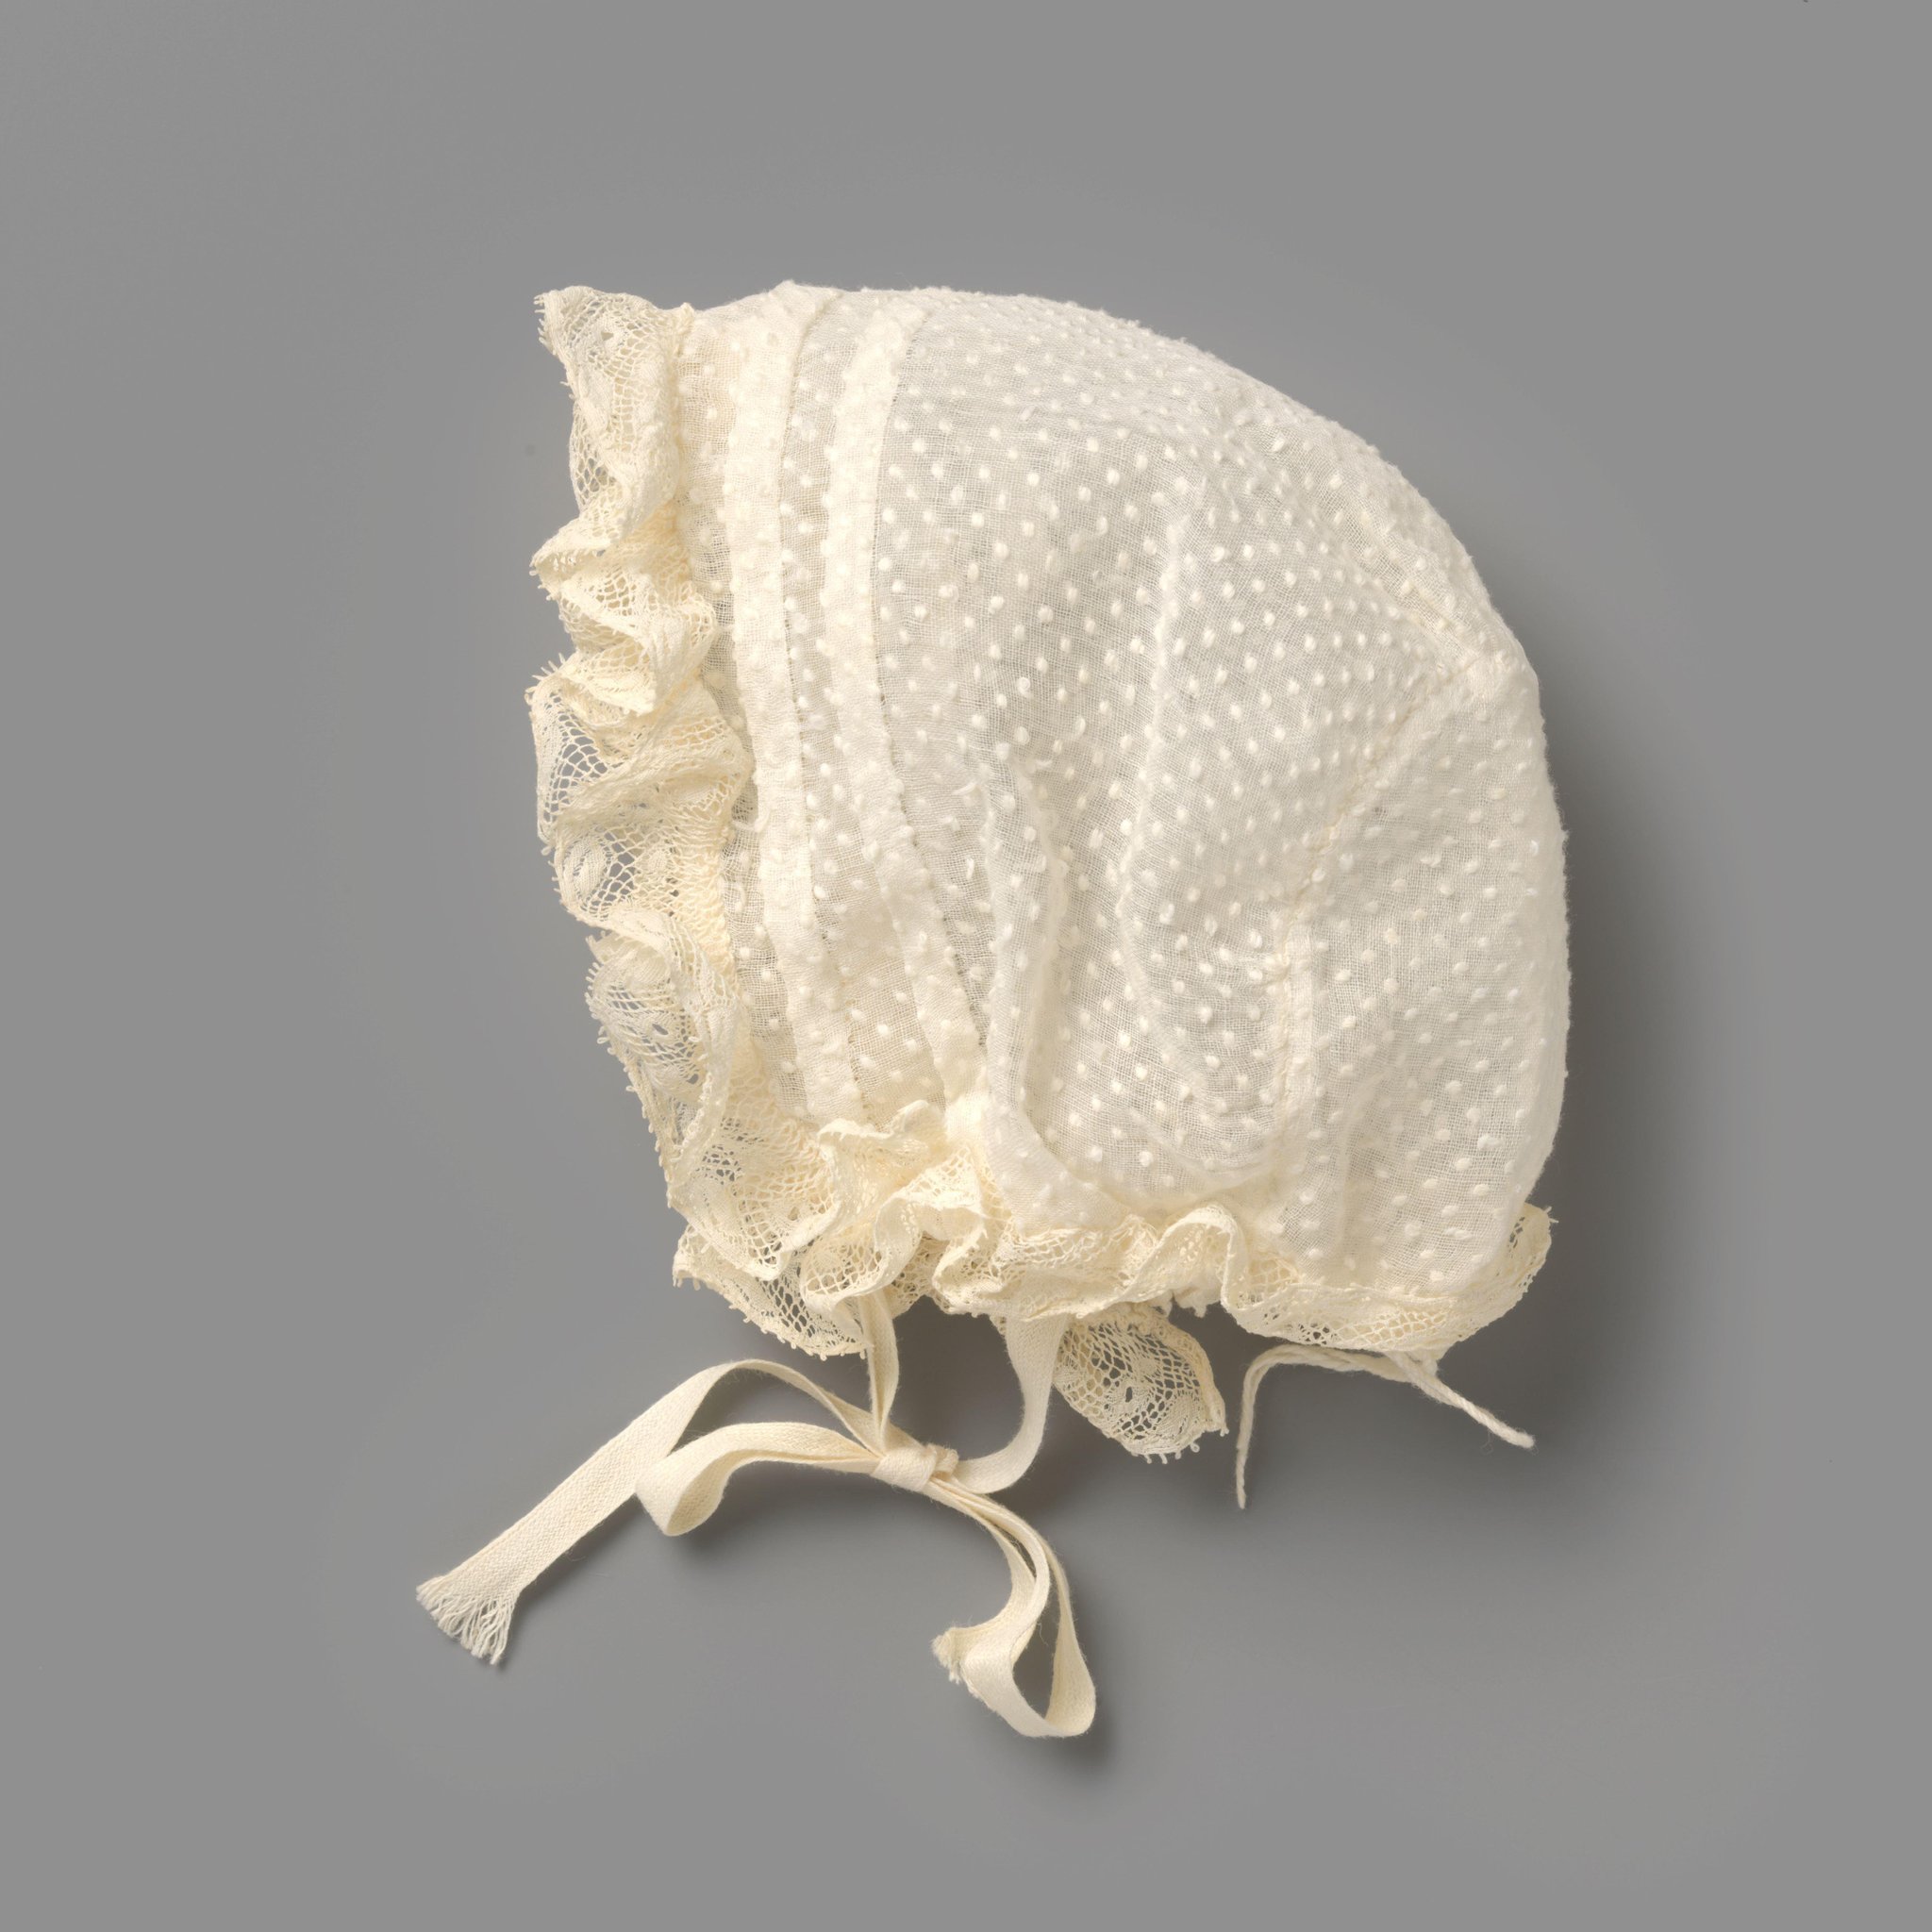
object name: girls' wear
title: Meisjesmuts van linnen, batist en genopt neteldoek, afgezet met twee oprijgen en kloskant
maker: Anonymous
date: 1890-1909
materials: textile, linen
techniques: lace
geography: netherlands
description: Babymutsjes van linnen, batist en genopt netelboek met hoefijzervormige of ronde bol (voor meisjes), versierd met strookjes kloskant. Belle Époque. Patroon: Het neteldoek is alleen in het voorpand versierd met twee oprijgjes. Vòòrlangs een dubbele en achterlangs een enkele valenciennes strook. Toestand. In 1979 gewassen.